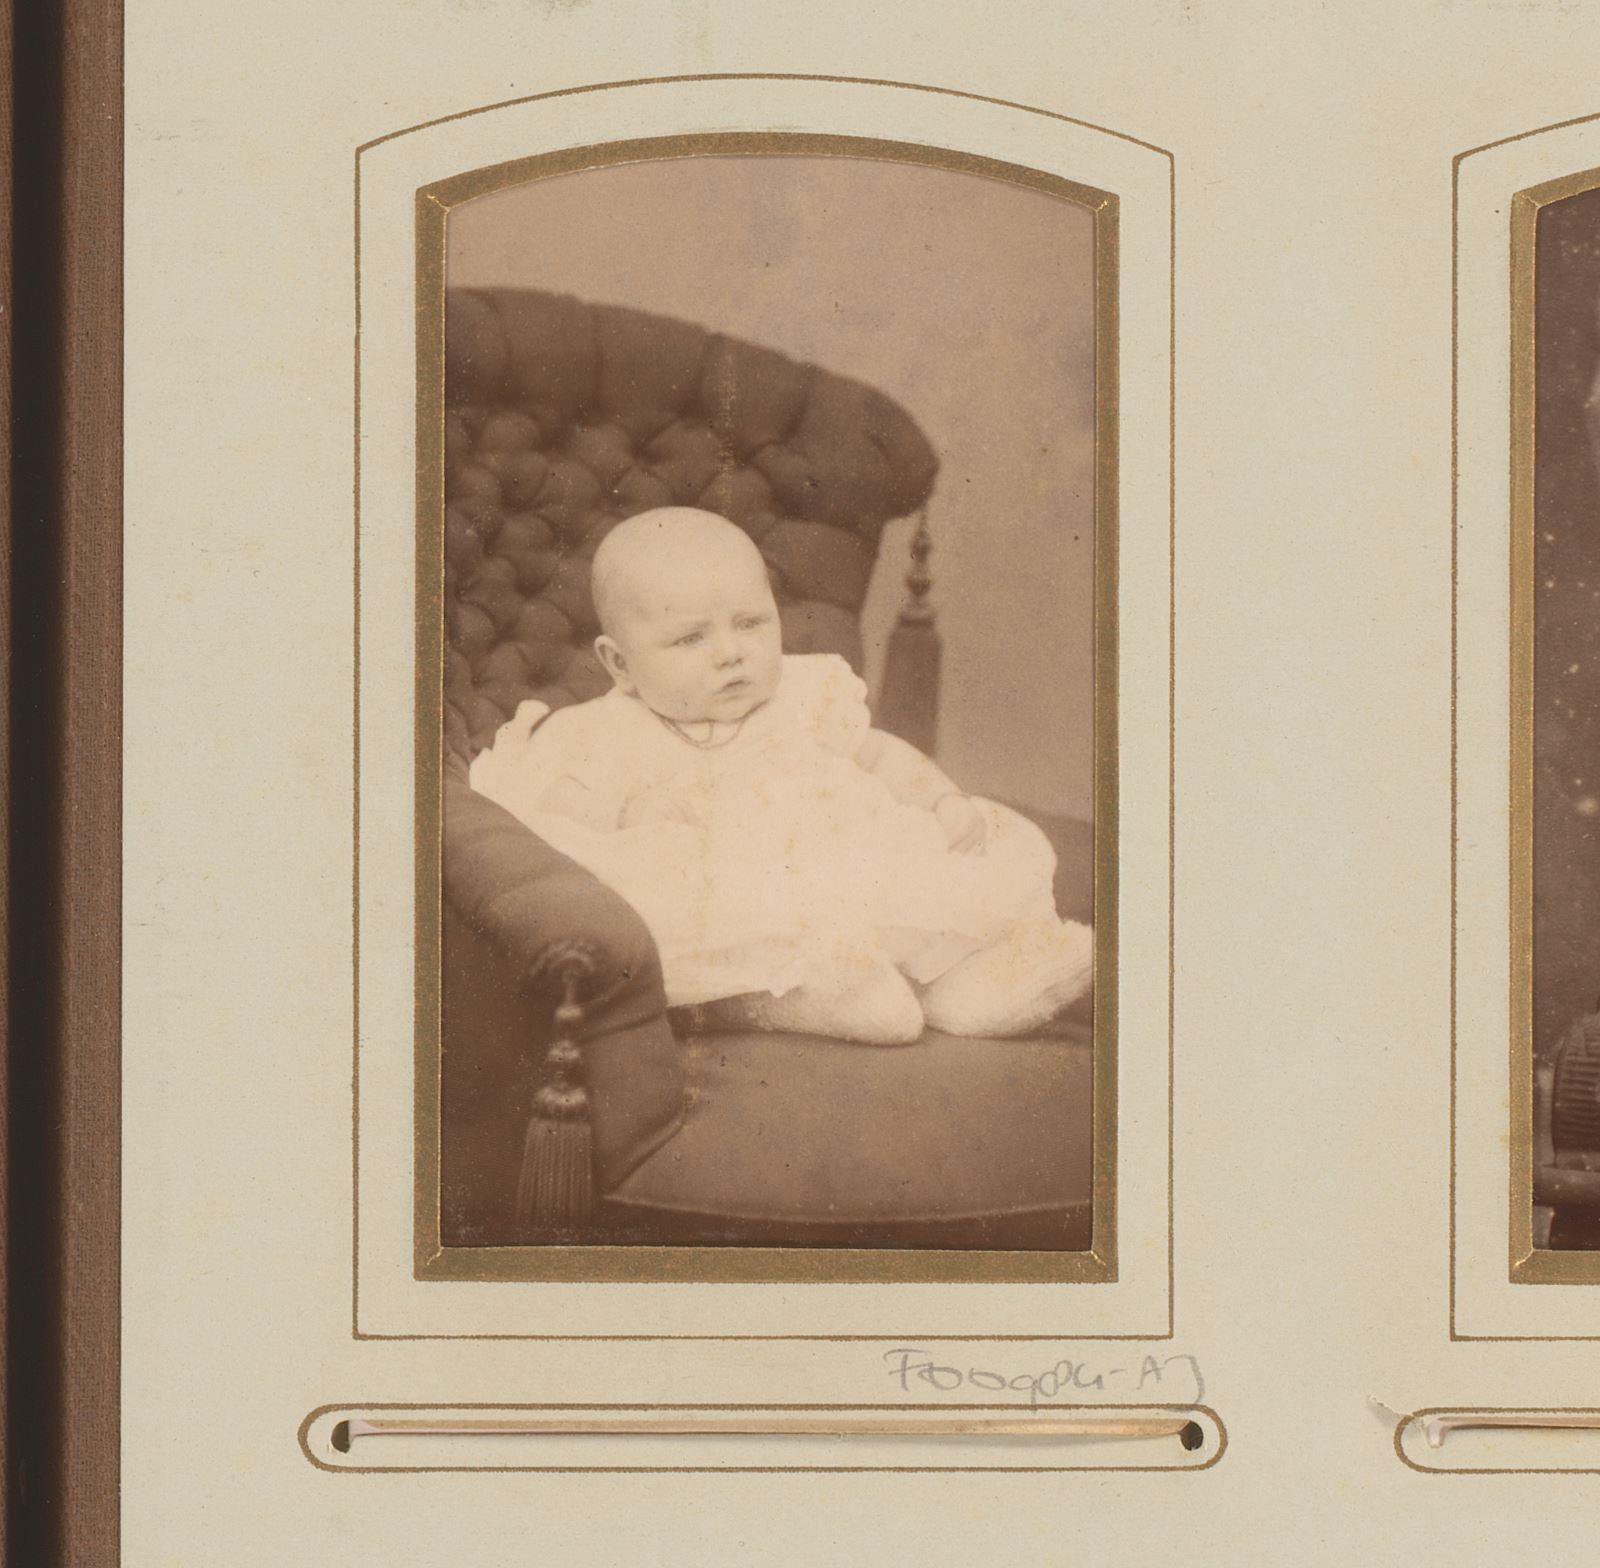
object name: carte de visite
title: Portret van een baby, zittend in een fauteuil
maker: b.j. pottjewijd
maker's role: fotograaf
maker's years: 1859-1941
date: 1880-1900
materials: cardboard, photographic support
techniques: albumen print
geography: winschoten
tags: sitting figure, historical persons, infant, baby ~ the ages of man, chair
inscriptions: inscription: ‘(...)/ Photographie/ B. J. Pottjewijd/ Winschoten./ Het negatief blijft voor nabestelling bewaard./ Vergrootingen in alle afmetingen.’